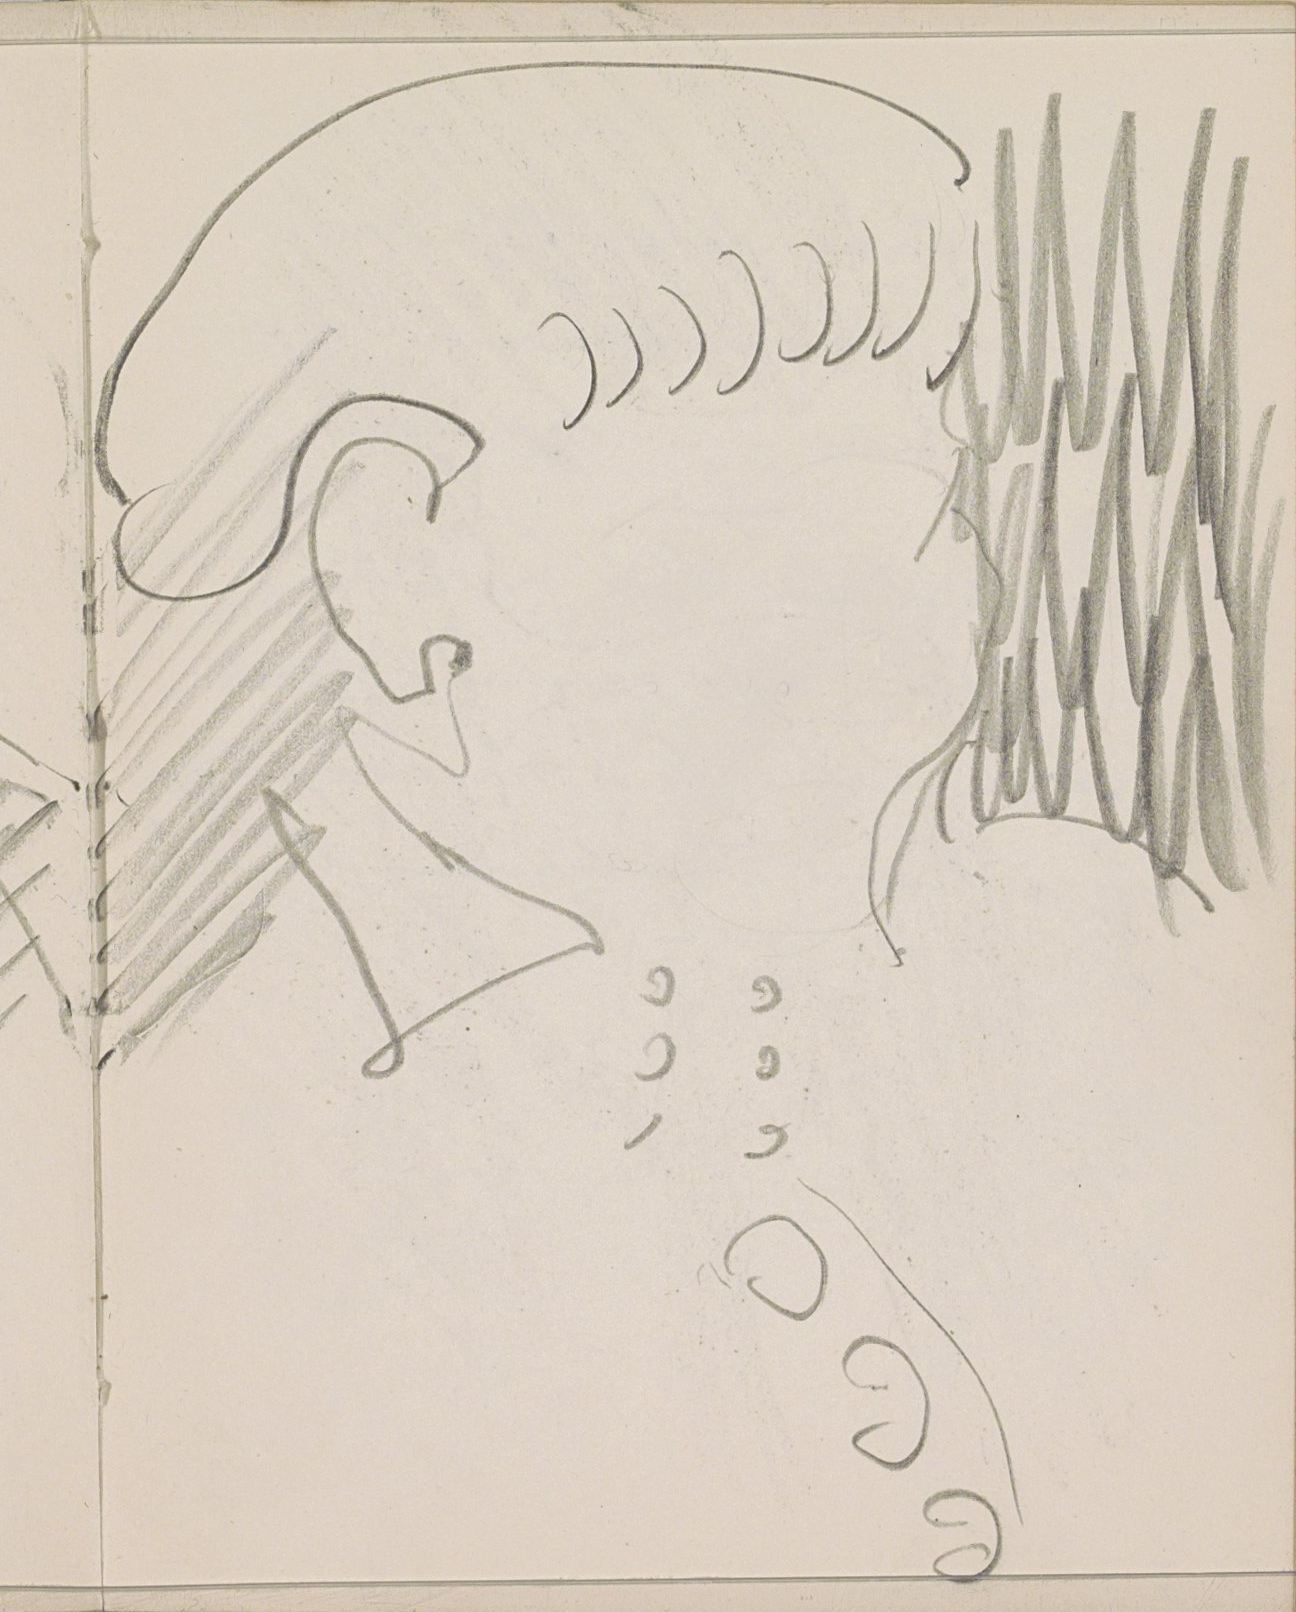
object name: sketchbook leaf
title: Silhouet van een vrouw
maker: reijer stolk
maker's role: draughtsman, print maker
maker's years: 1896-1945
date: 1916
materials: paper, pencil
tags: head (human) - aa - female human figure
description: De vrouw draagt een blouse met knopen en draagt het haar uit het gezicht gekamd. Blad 12 recto uit een schetsboek met 72 bladen.